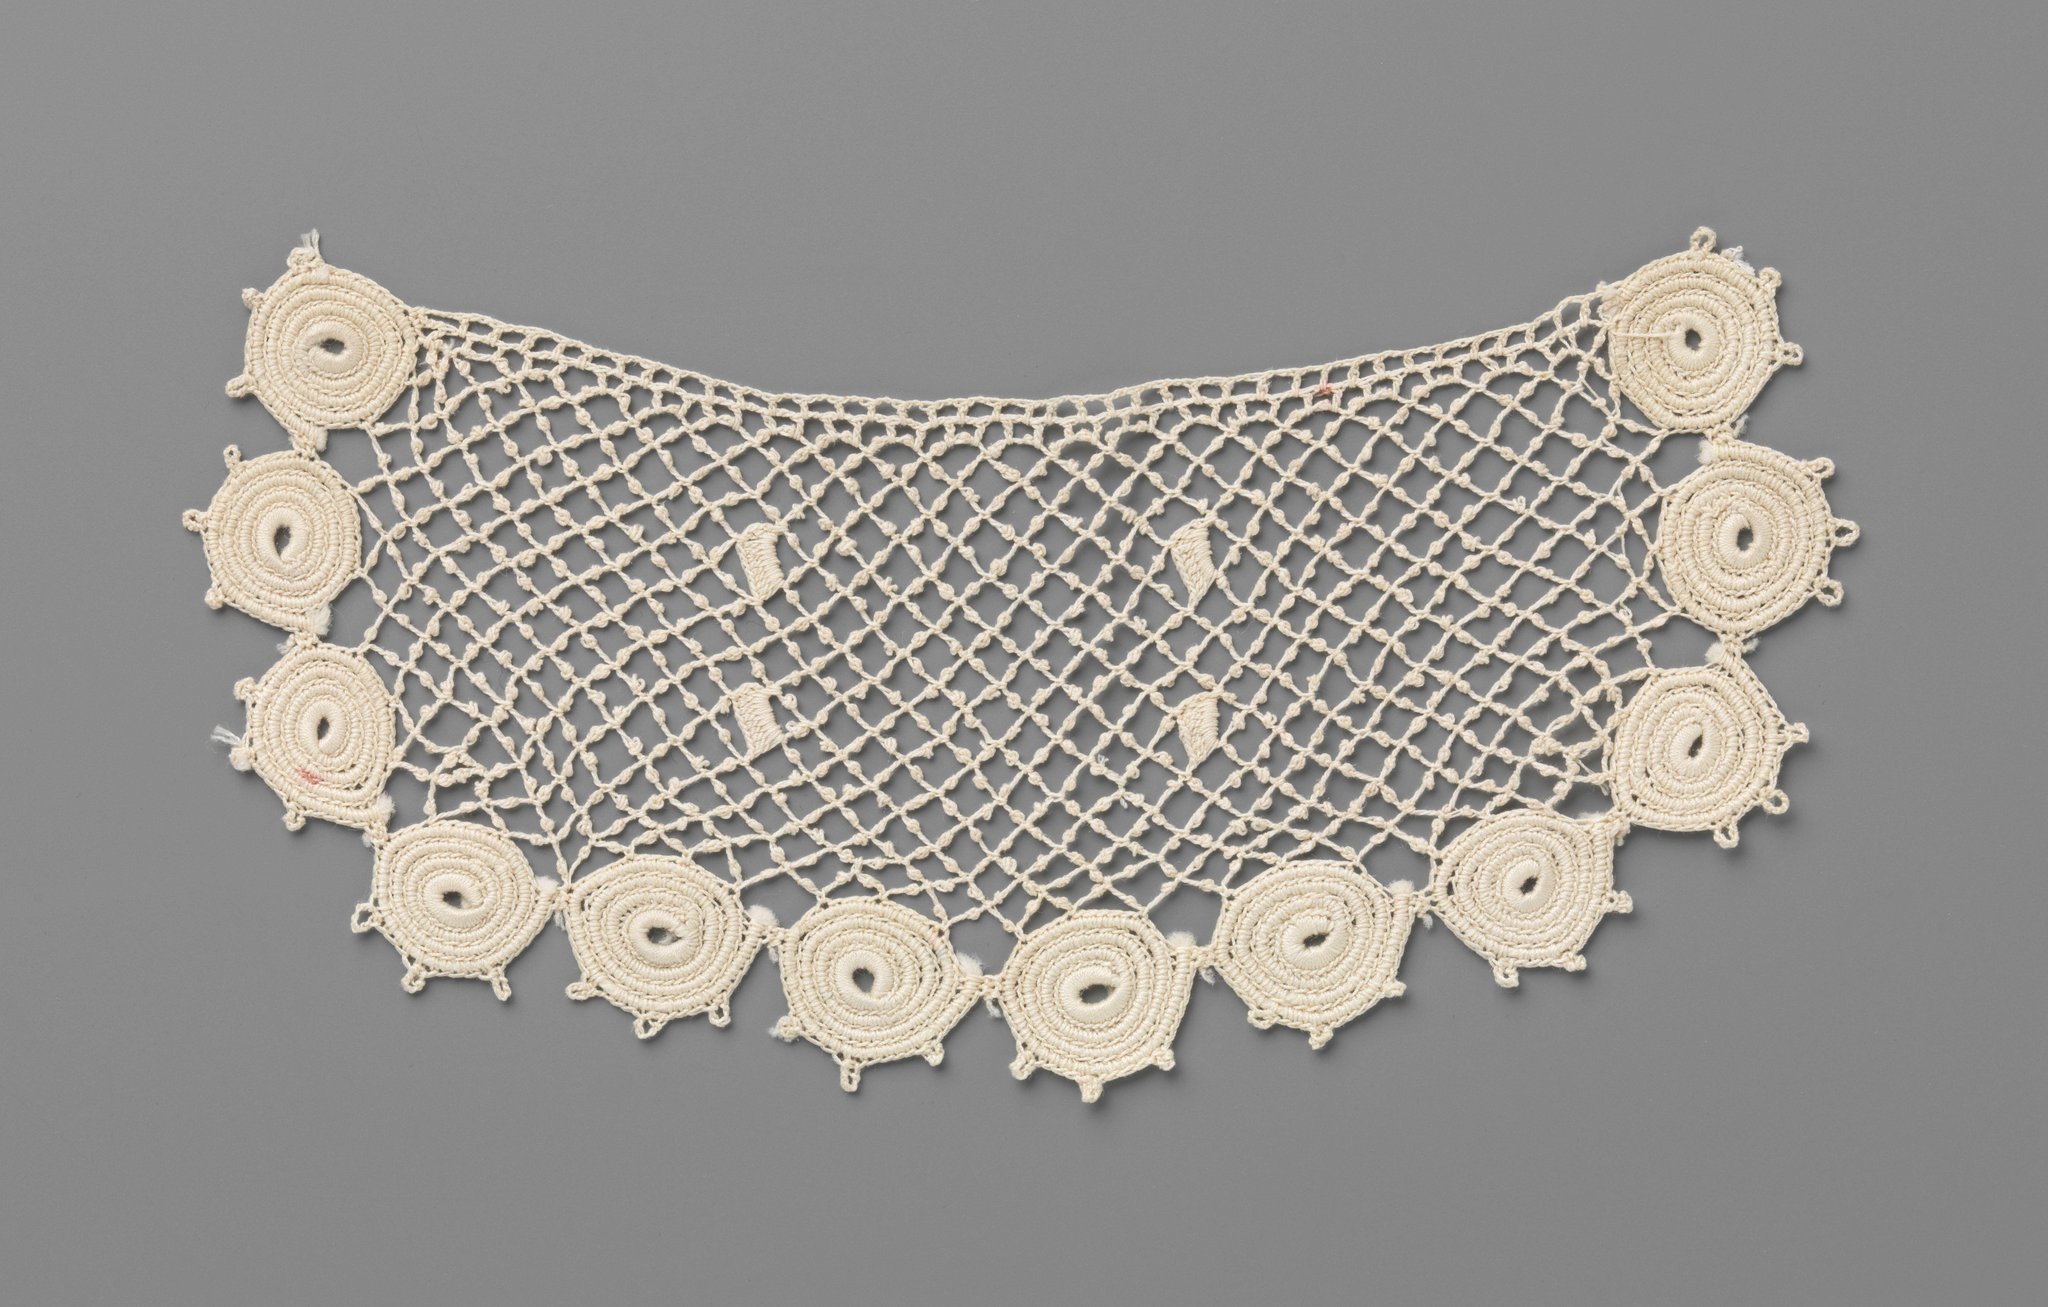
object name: womenswear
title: Manchet van gehaakte kant met ronde spiraalschulpen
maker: Anonymous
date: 1930-1935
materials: cotton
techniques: crocheted lace, irish crochet lace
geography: amsterdam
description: Manchet van naturelkleurige Ierse gehaakte kant. Rechthoekig model met afgeronde hoeken. Vier moesjes, licht gebogen rechthoekjes, in twee rijen in een ruitvormige netwerk met picots. Aan drie zijden afgewerkt met een schulpenrand van aaneengeschakelde ronde spiraalschulpen, die worden gevormd door een rondgelegde en omgehaakte draadbundel. De bovenzijde is recht afgewerkt.